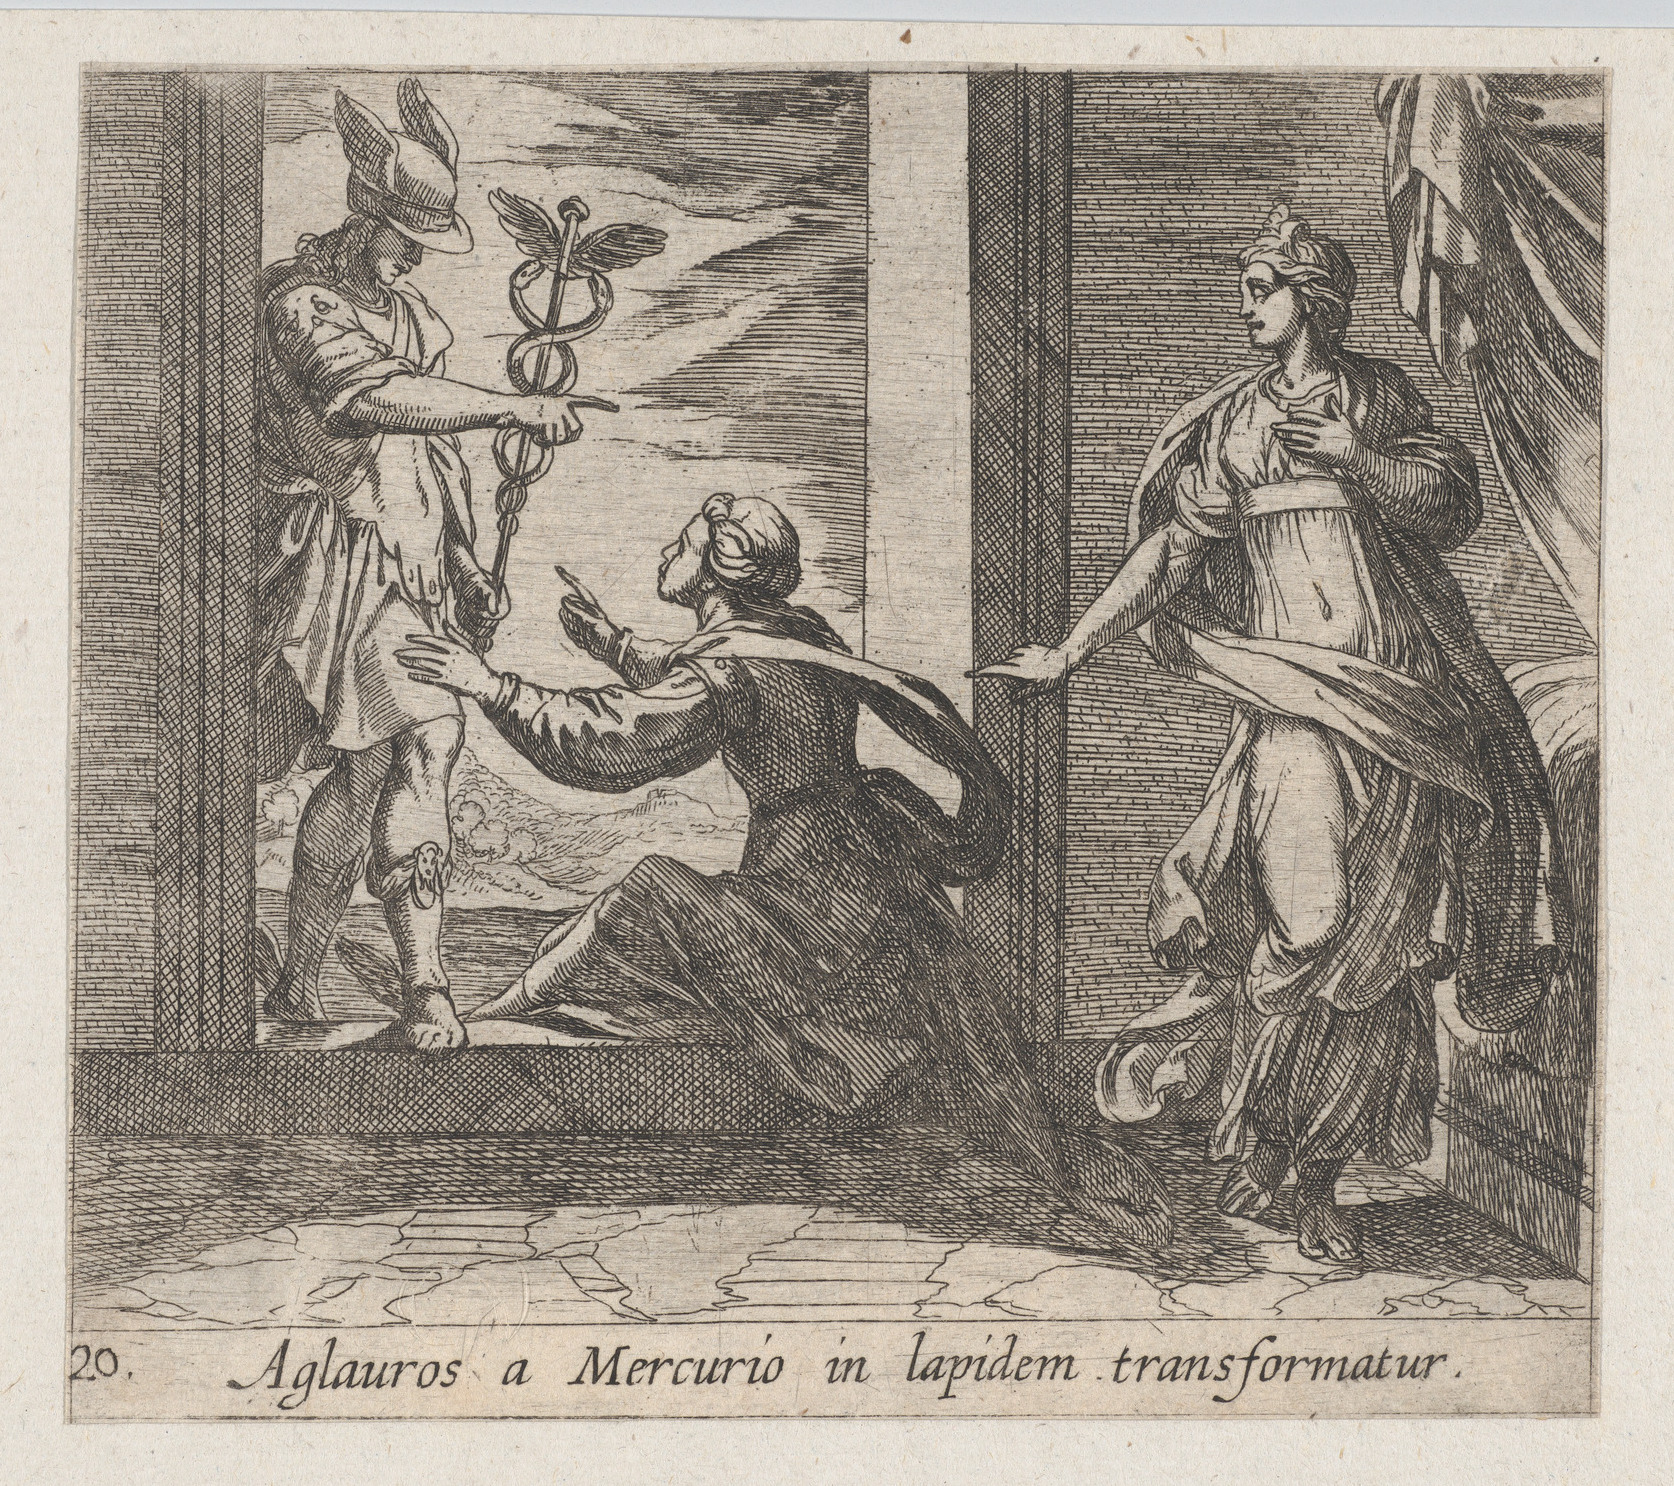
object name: print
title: Plate 20: Mercury Turning Aglauros to Stone (Aglauros a Mercurio in lapidem transformatur), from Ovid's 'Metamorphoses'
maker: antonio tempesta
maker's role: artist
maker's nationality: italian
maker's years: 1555-1630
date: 1606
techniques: etching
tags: men,women,mercury